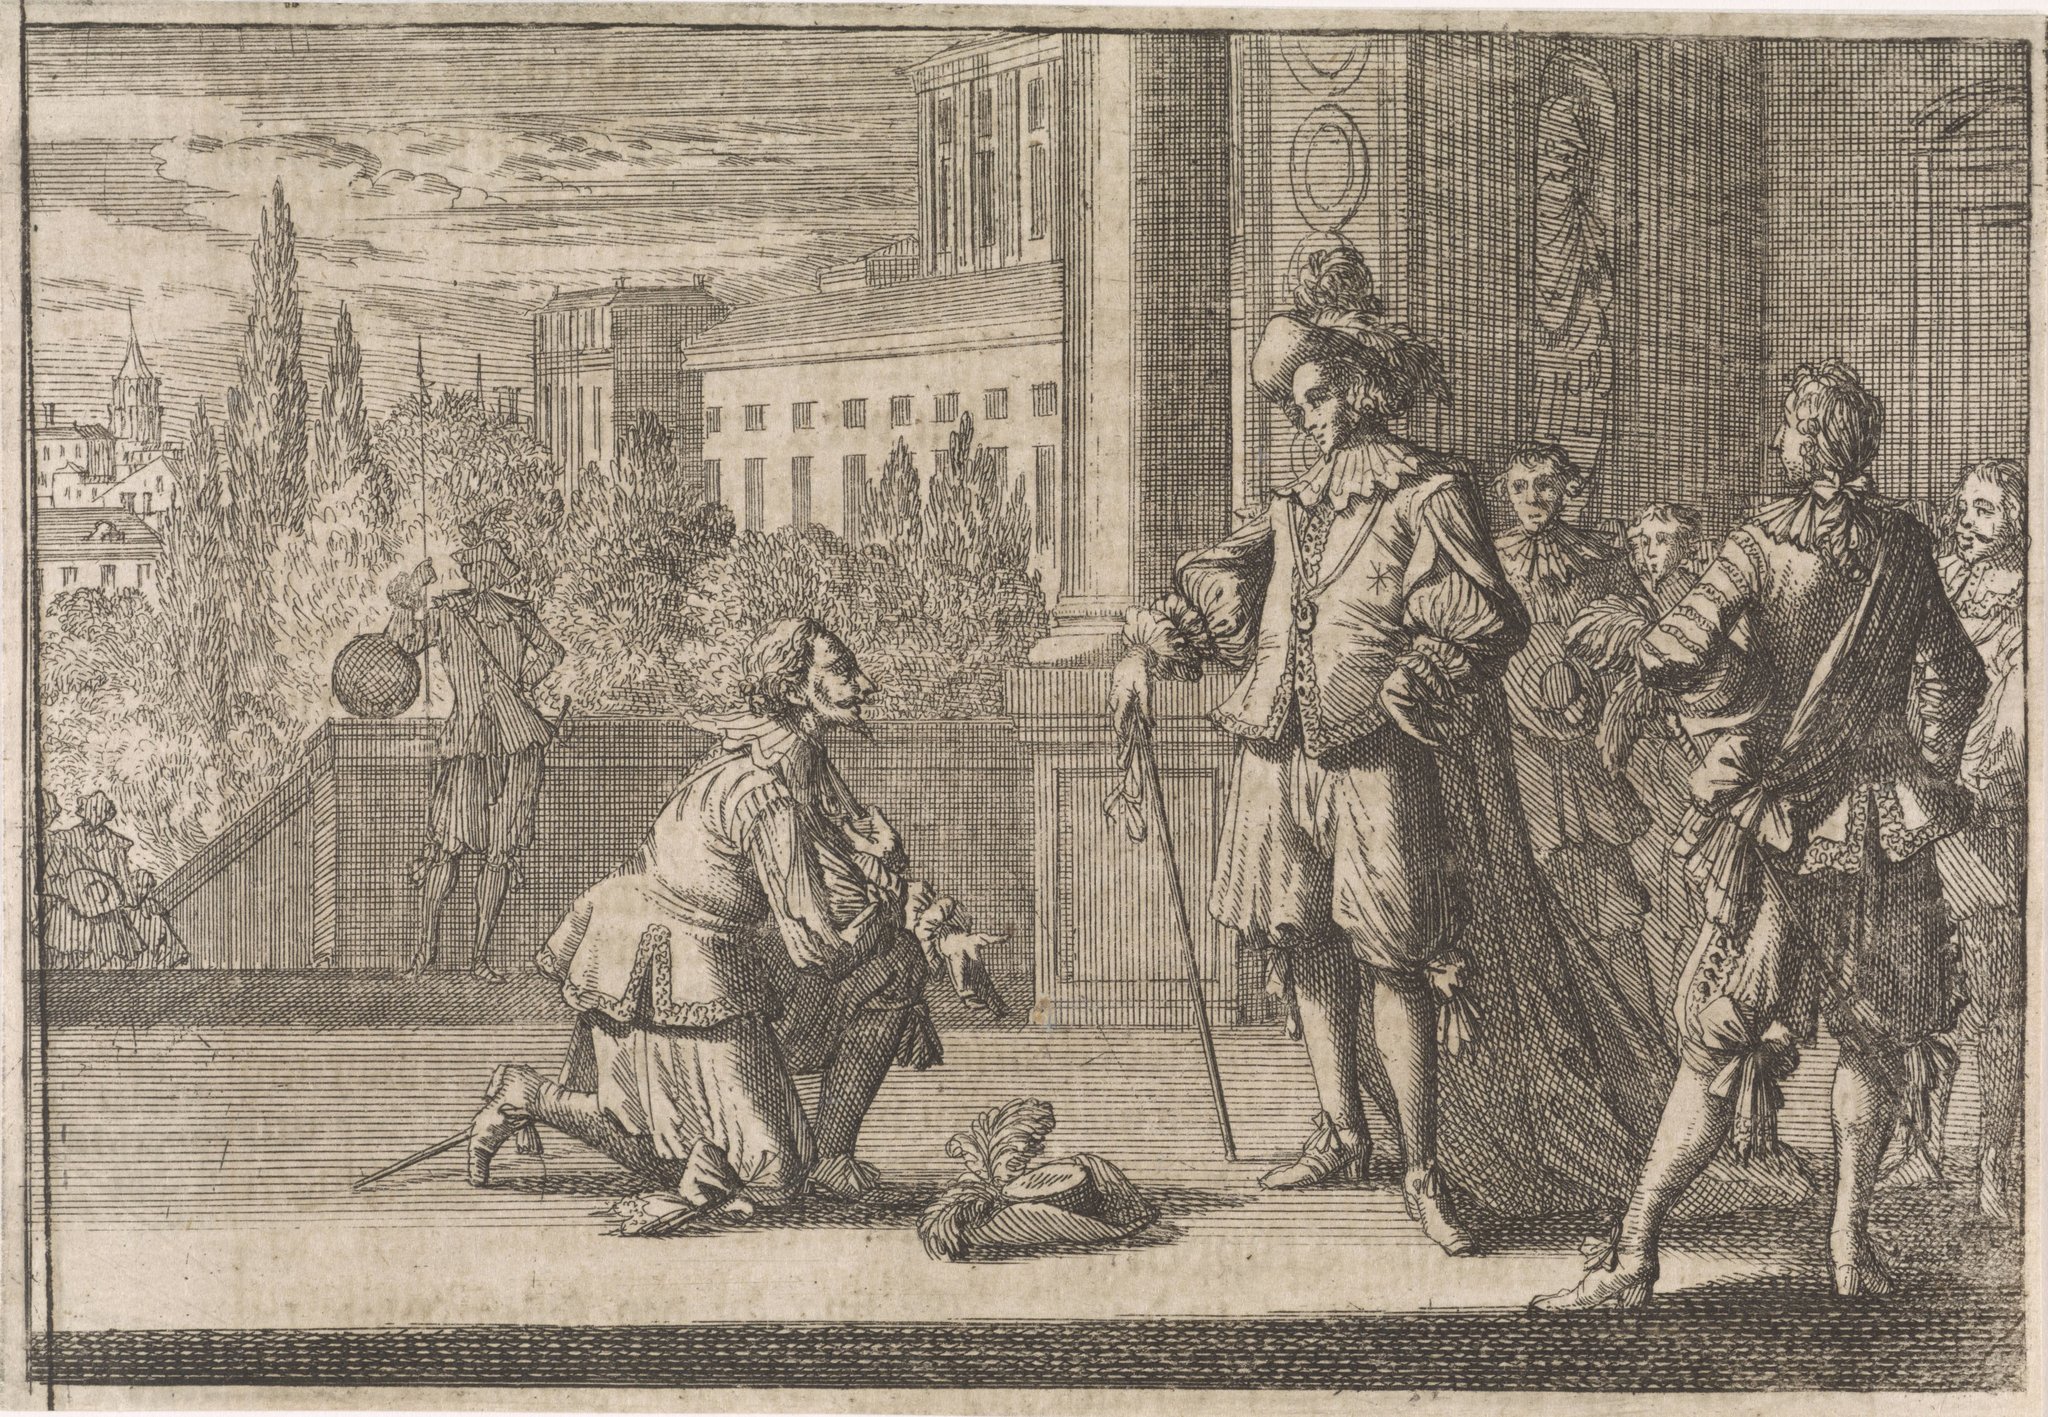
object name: book illustration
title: Karel IV, hertog van Lotharingen knielt voor Lodewijk XIII, 1641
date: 1701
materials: paper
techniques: etching, letterpress printing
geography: frankfurt am main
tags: karel iv hertog van lotharingen, lodewijk xiii (koning van frankrijk), kneeling figure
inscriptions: collector's mark: Lugt 2228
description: Boekillustratie voor Hiob Ludolff. Allgemeine Schau-Bühne der Welt. Deel II. Frankfurt am Main: Johann David Zunnern, 1701, p. 877.